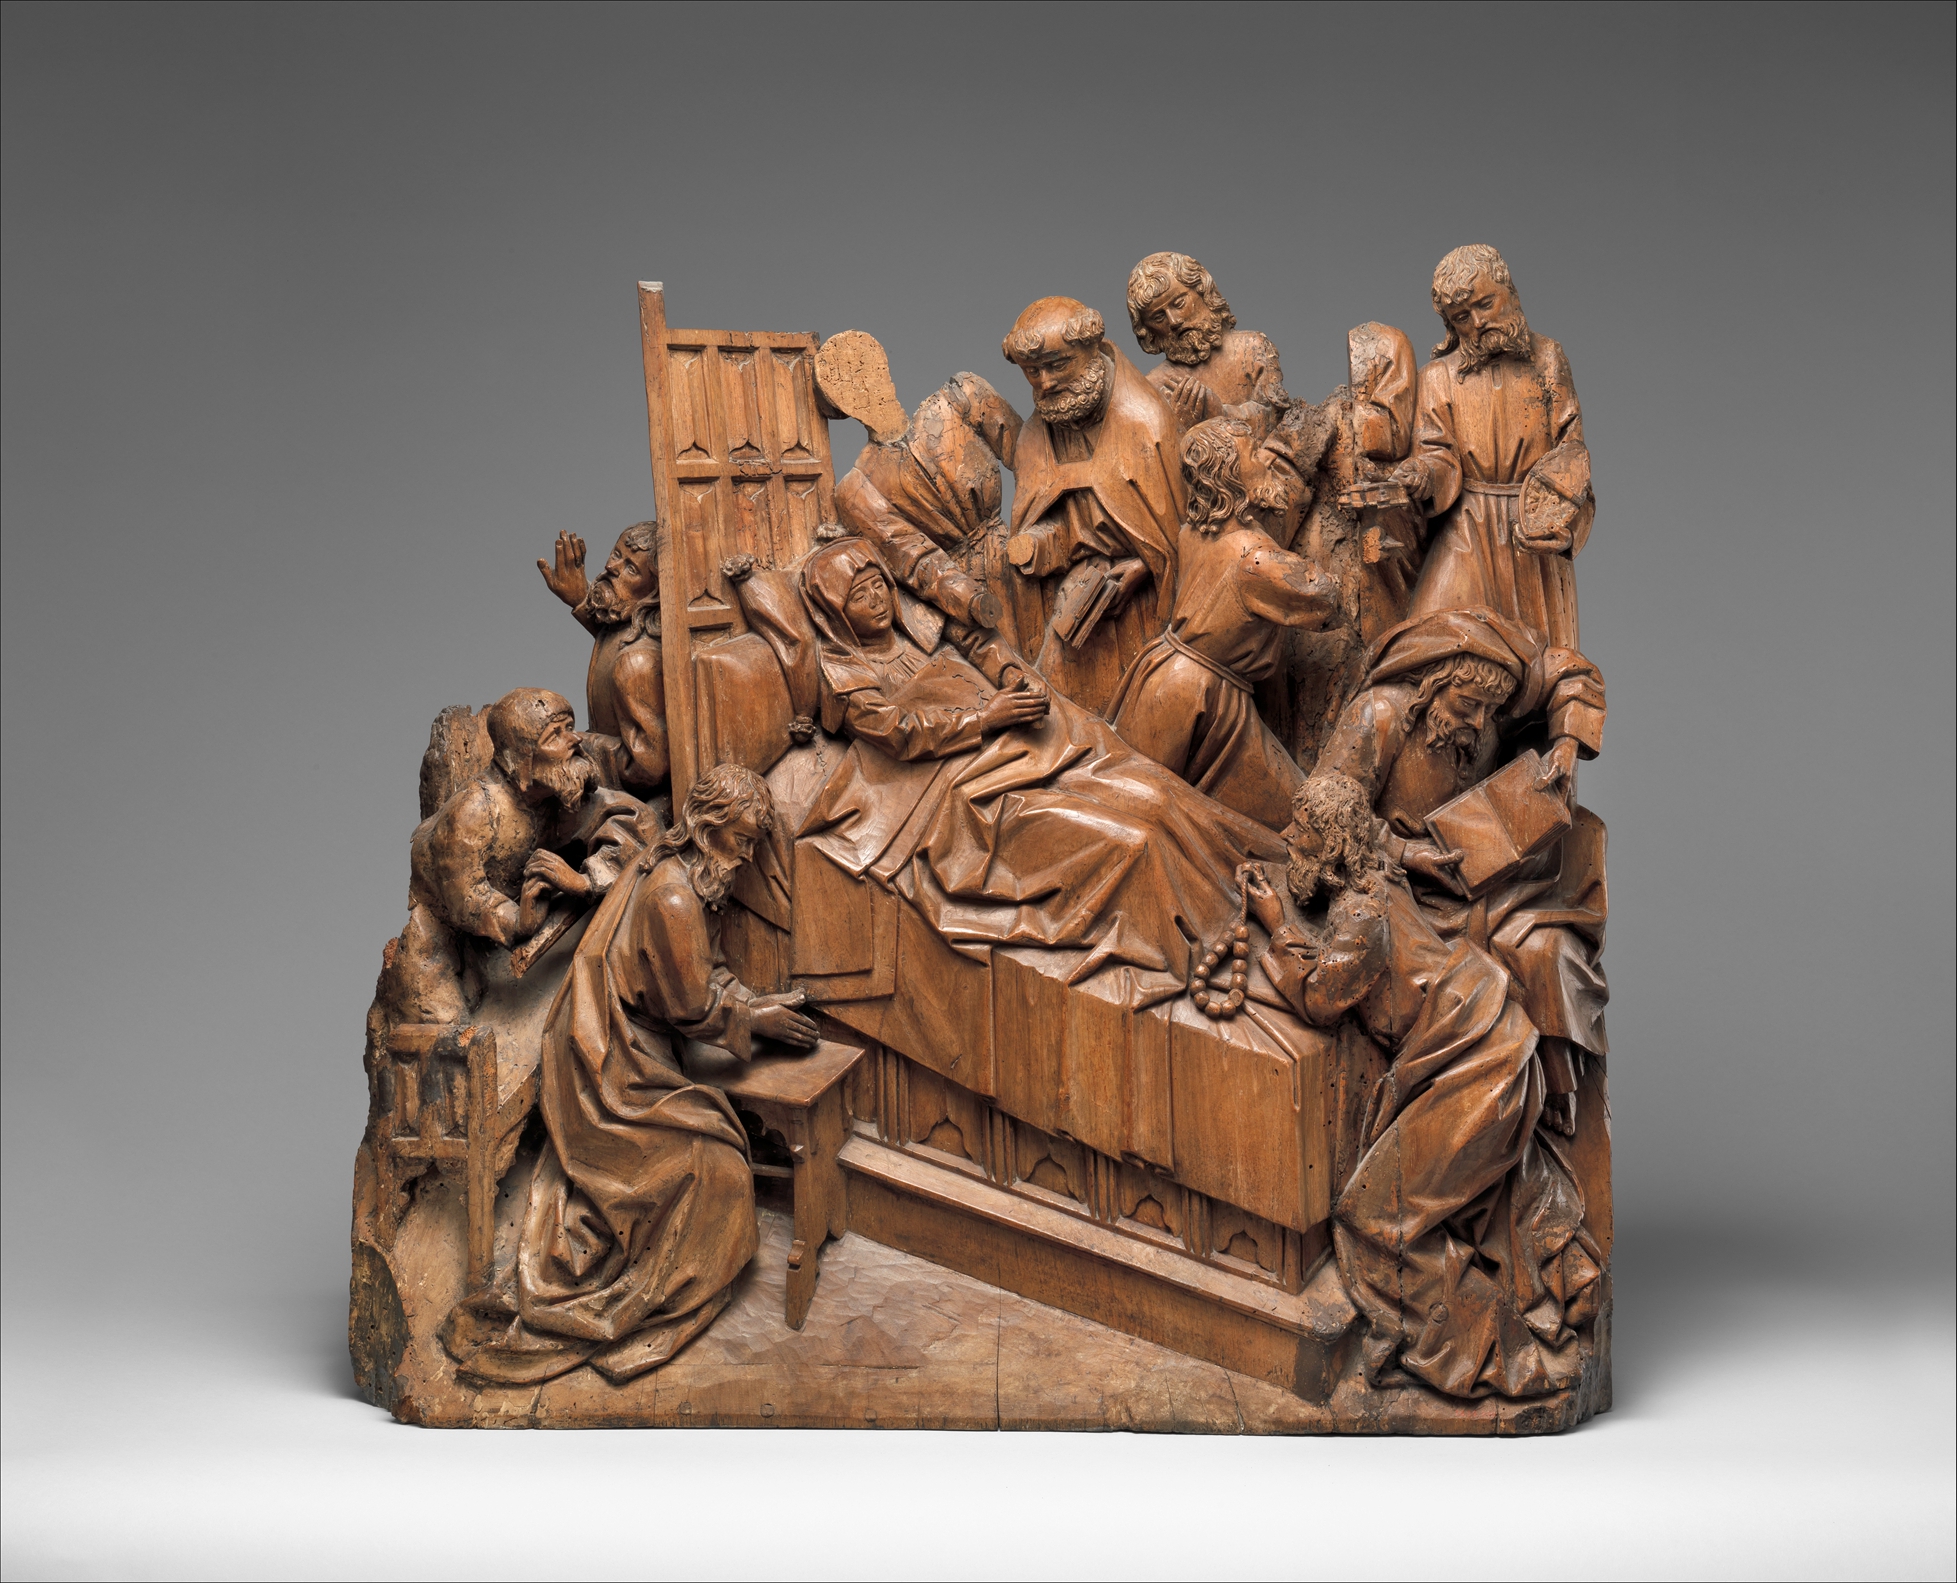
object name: relief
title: Death of the Virgin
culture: south netherlandish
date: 1501-1533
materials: wood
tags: sadness,men,death,beds